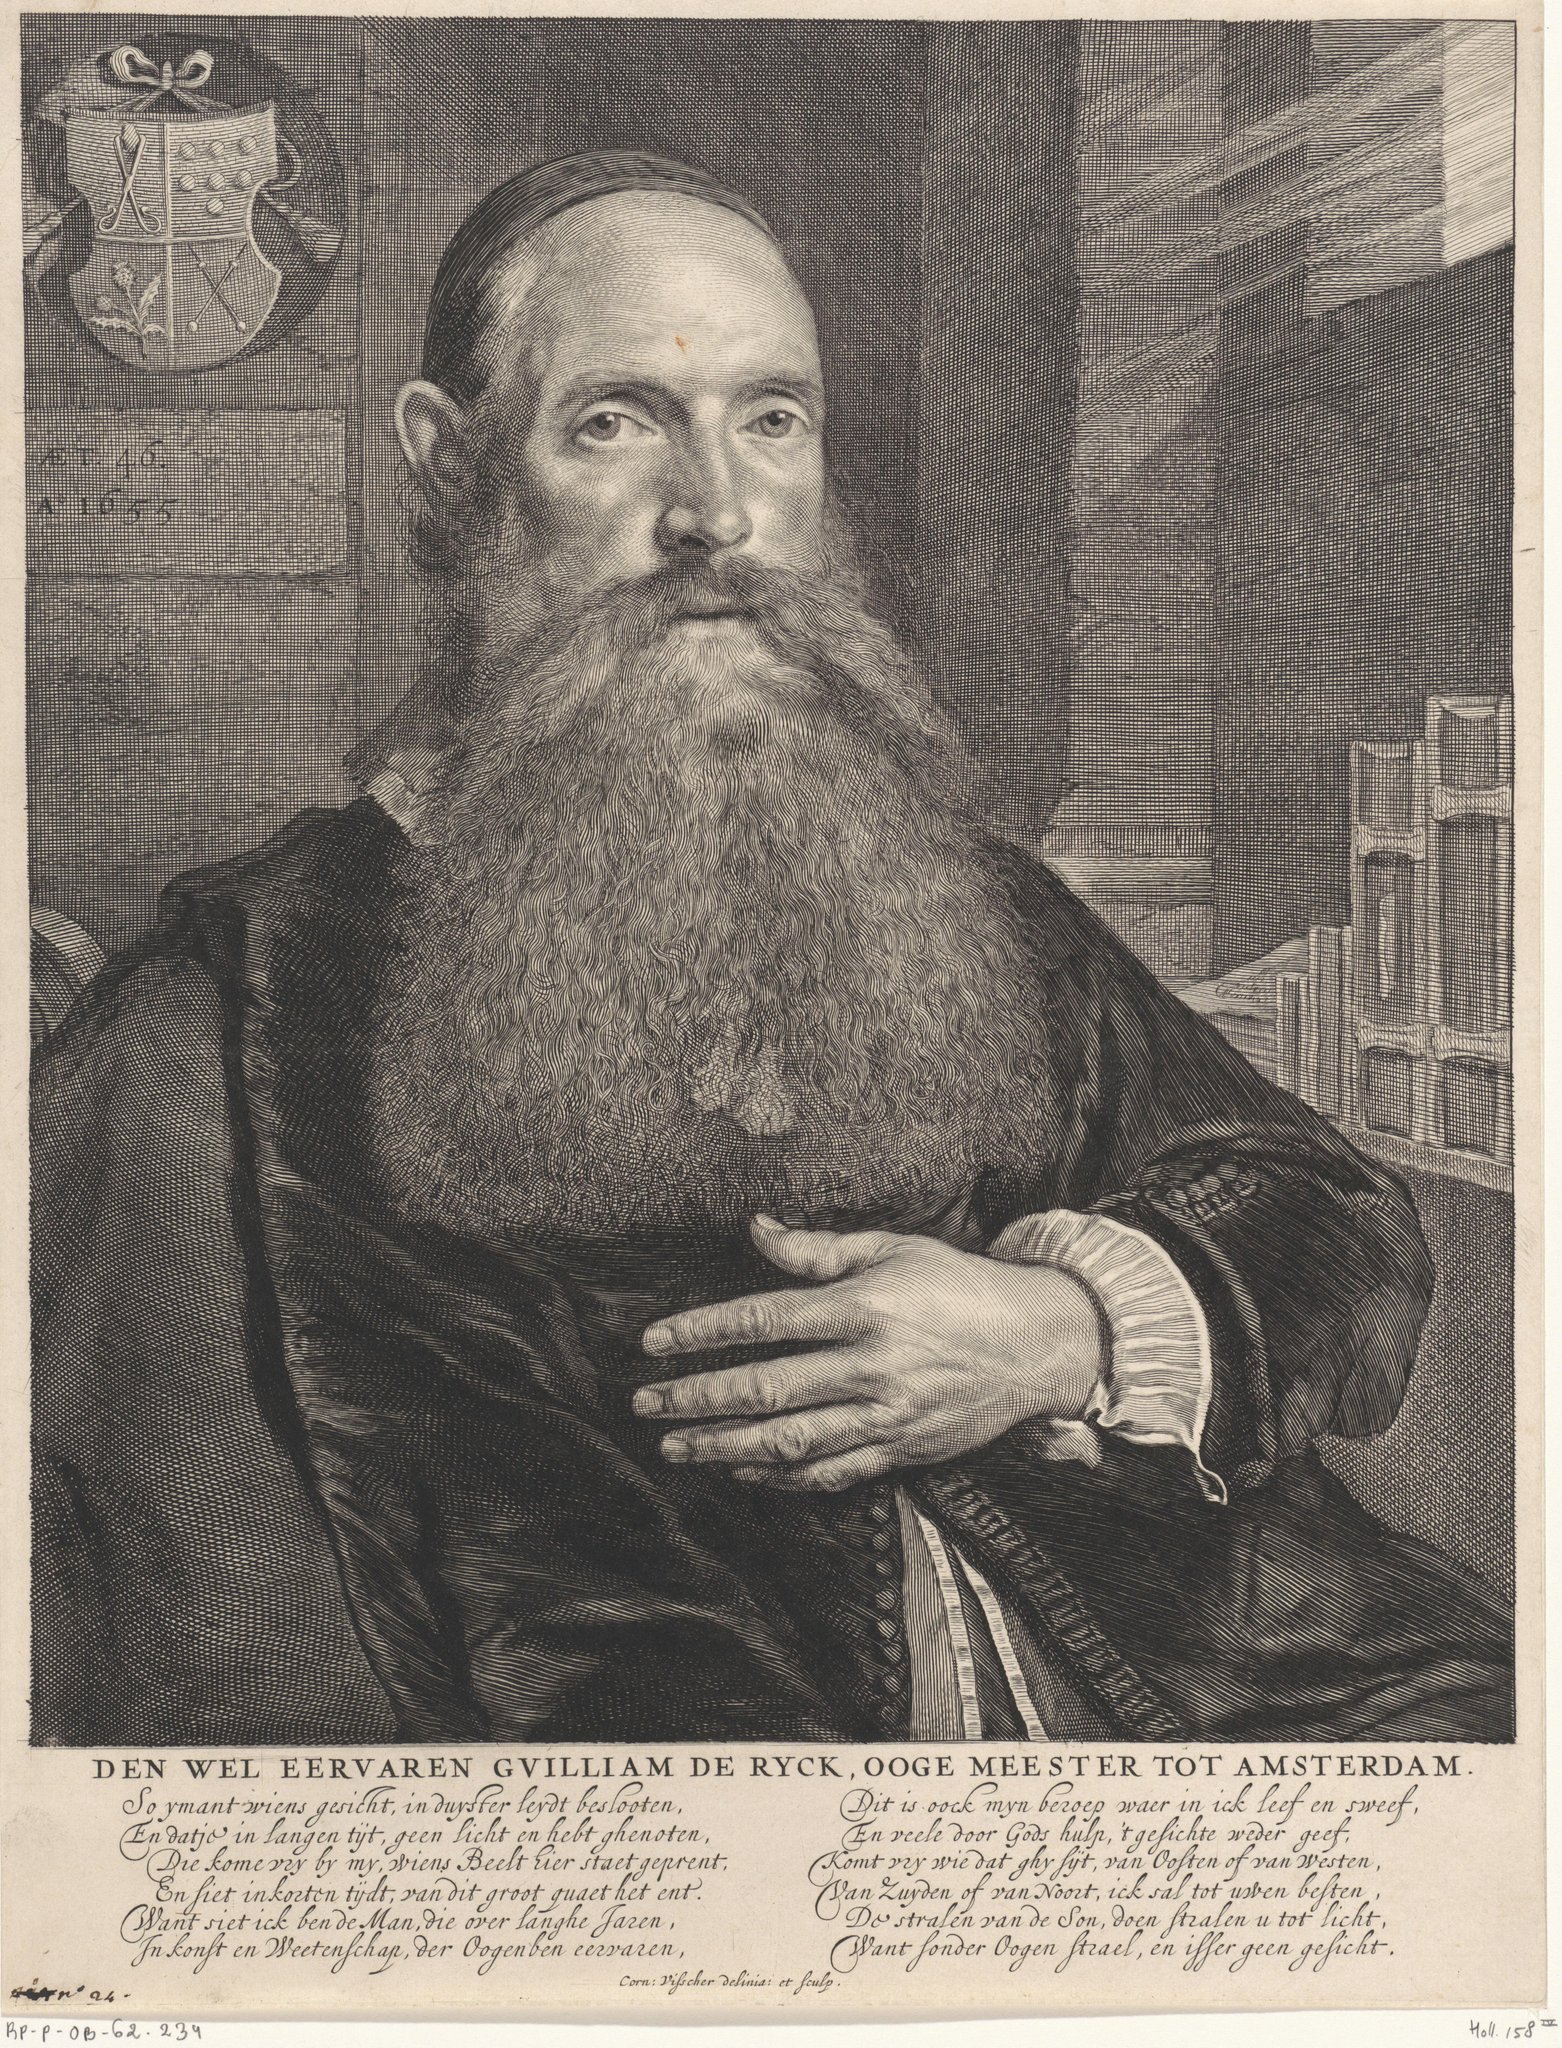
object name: print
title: Portret van Willem de Rijck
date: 1655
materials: paper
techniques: engraving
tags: book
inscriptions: collector's mark: Lugt 240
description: De Amsterdamse oogarts Willem de Rijck op 46-jarige leeftijd. Hij heeft zijn hand op zijn borst. Naast hem staan boeken en achter hem hangt een wapenschild.